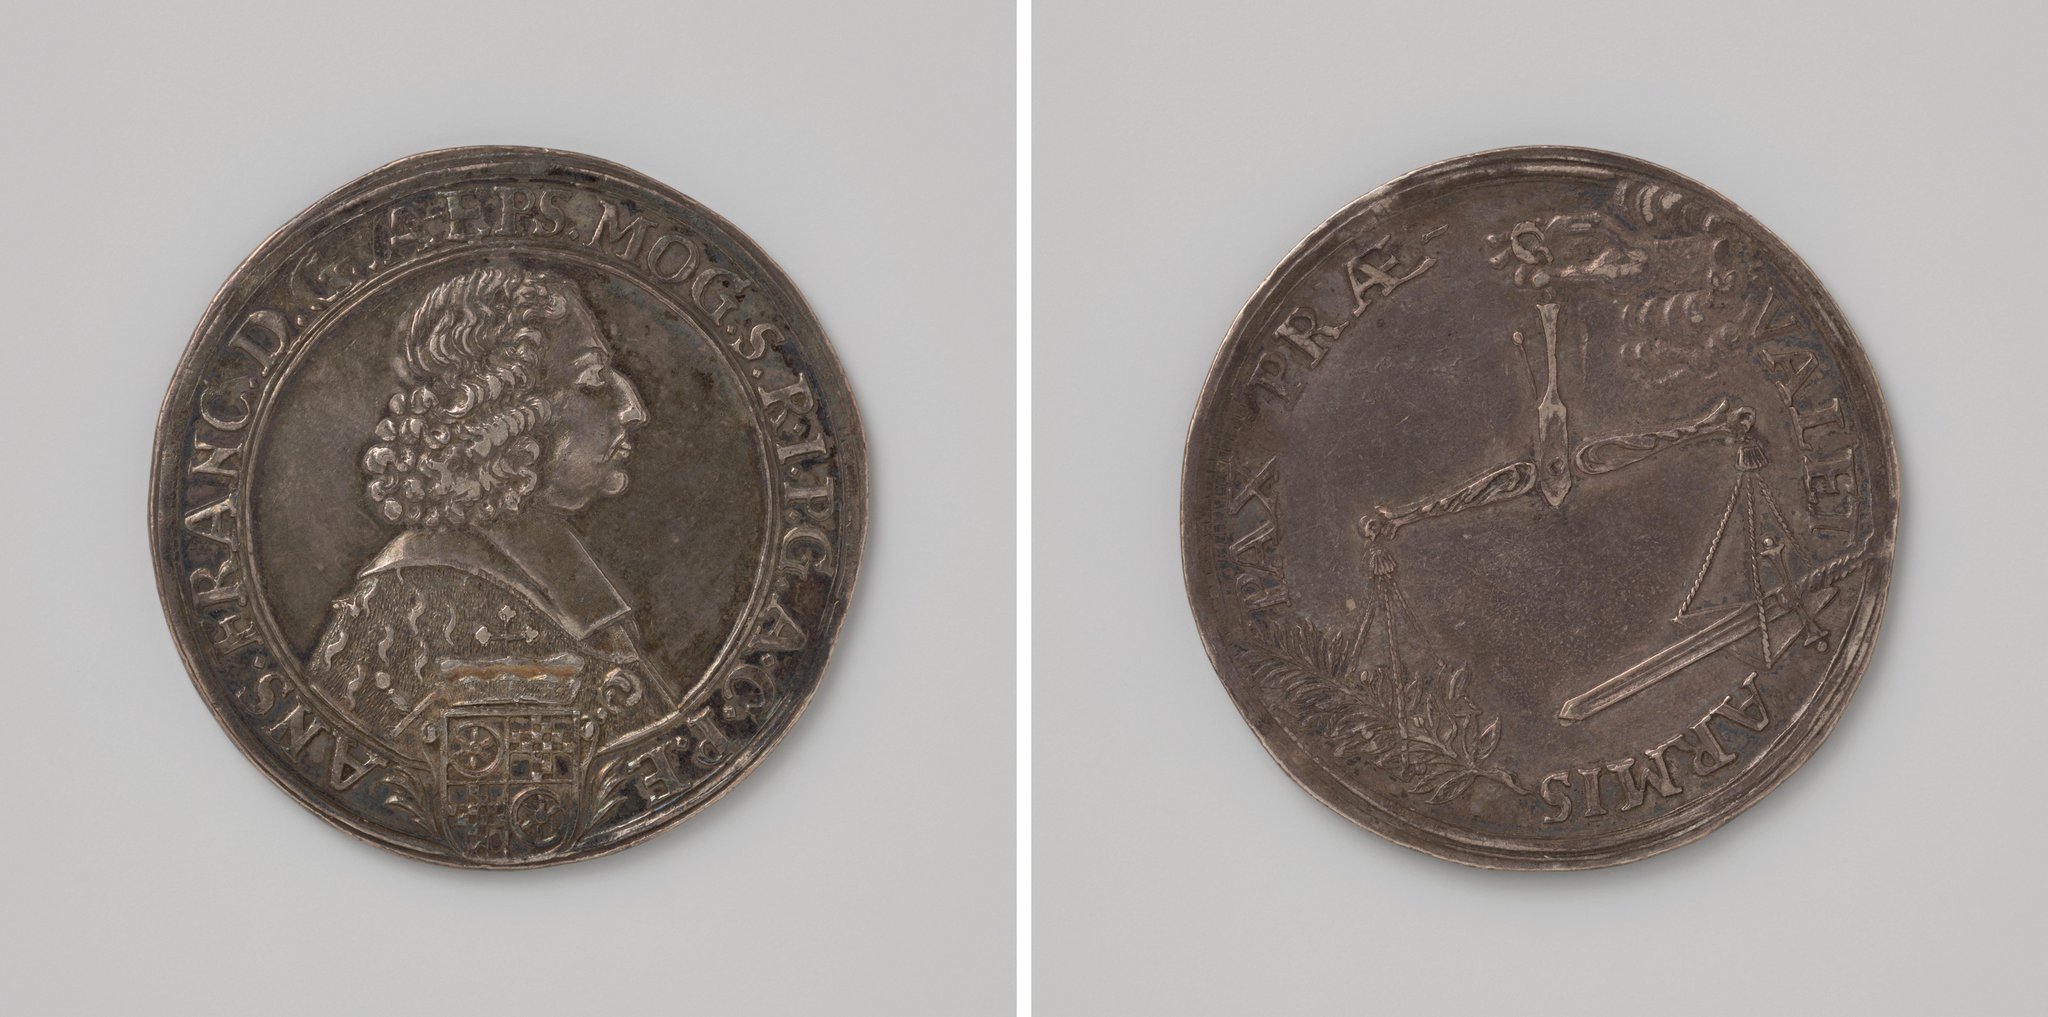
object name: taler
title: Taler over de Vrede van Nijmegen, ter ere van Anselm Frans graaf van Ingelheim, aartsbisschop van Mainz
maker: Anonymous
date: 1679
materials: silver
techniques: striking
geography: germany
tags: cologne, nijmegen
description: Zilveren taler. Voorzijde: borststuk man boven gekroond wapenschild binnen omschrift. Keerzijde: hand uit wolken weegt vredestakken op weegschaal af tegen zwaard binnen omschrift